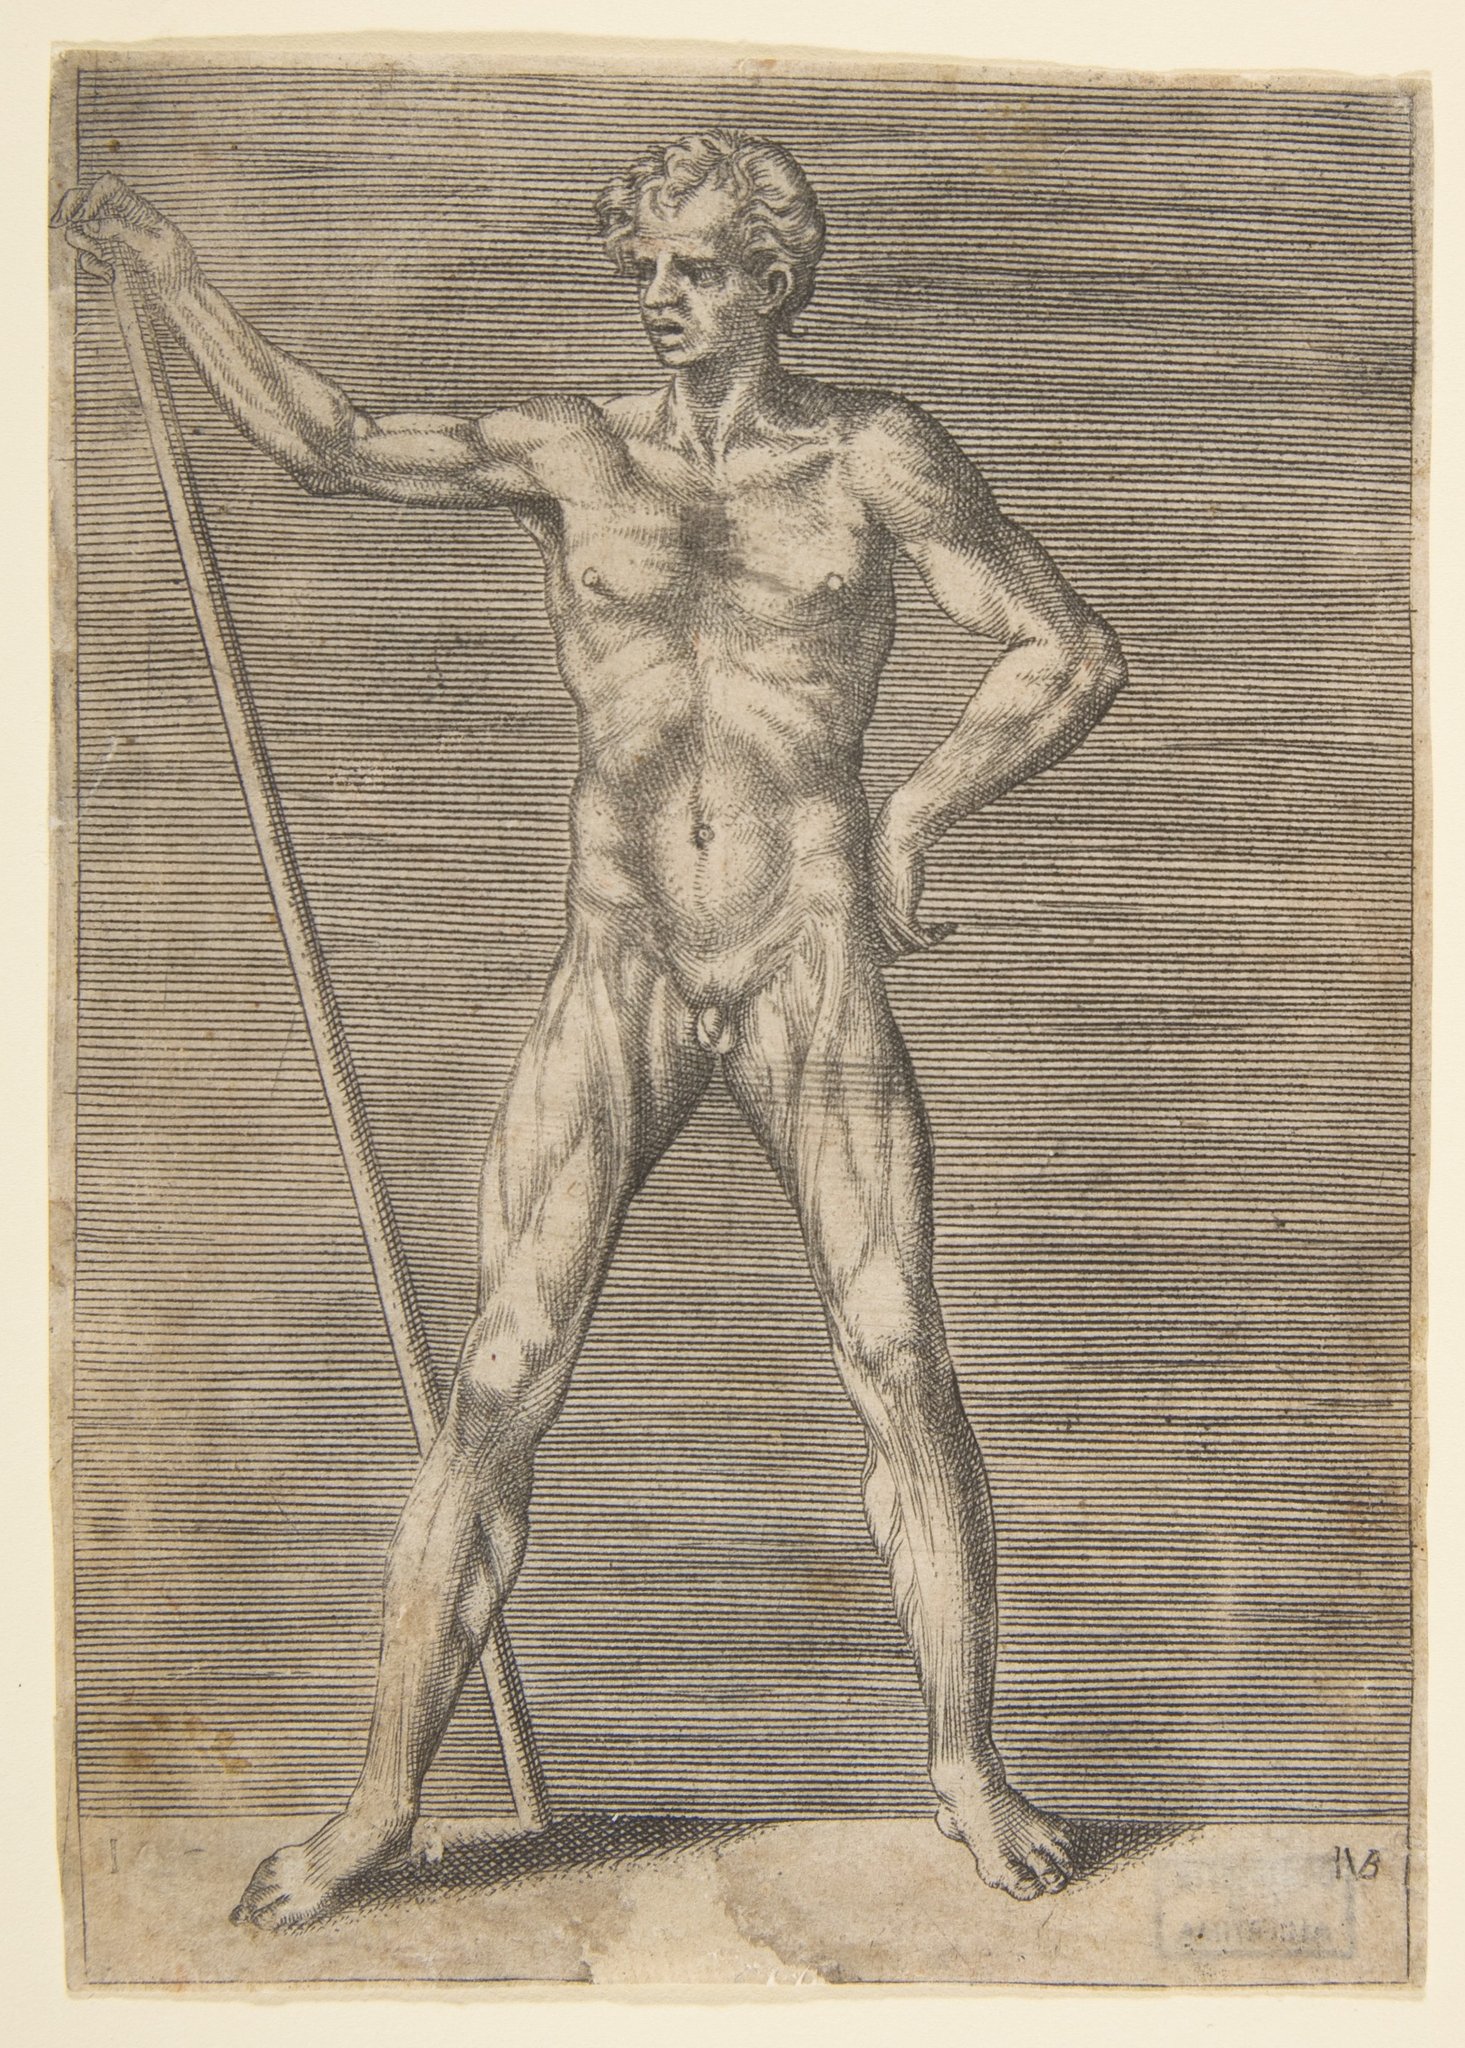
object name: print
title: Flayed man seen from in front, holding a stick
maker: giulio bonasone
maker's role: artist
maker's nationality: italian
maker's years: 1510-1576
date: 1531-1576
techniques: engraving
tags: male nudes